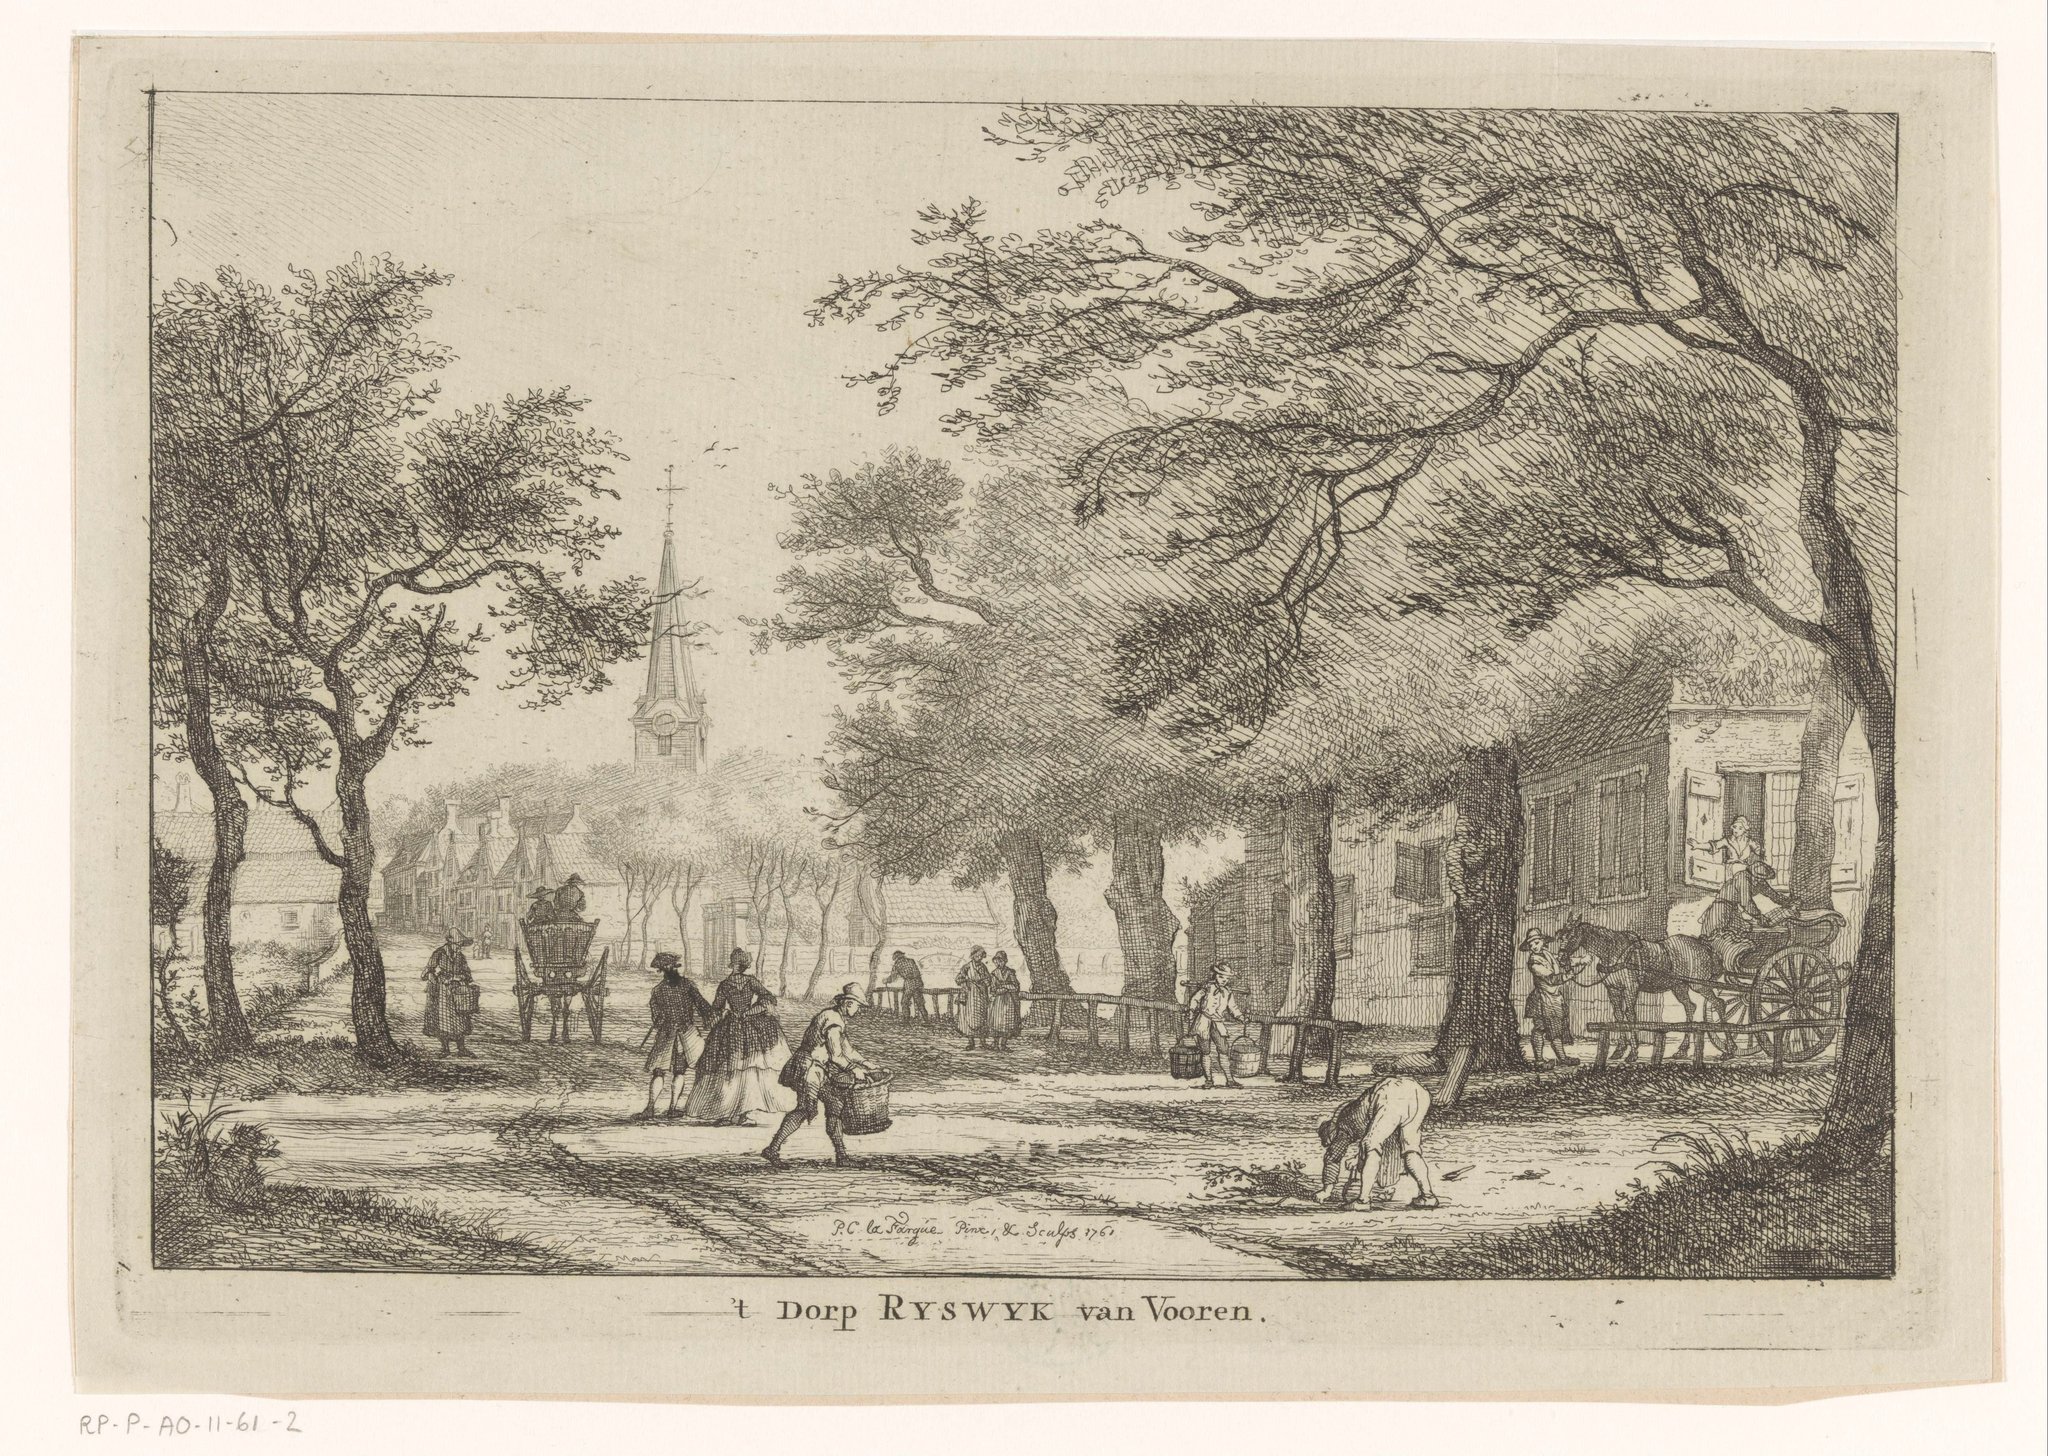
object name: print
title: 't Dorp Ryswyk van vooren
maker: paulus constantijn la fargue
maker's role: draughtsman, painter, print maker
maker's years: 1729-1782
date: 1761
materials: paper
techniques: engraving, etching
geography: the hague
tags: prospect of village, silhouette of village, church (exterior), public road in village (+ city(-scape) with figures, staffage)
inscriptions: collector's mark: Lugt 195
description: Gezicht op het dorp Rijswijk. Op de voorgrond een aantal figuren. Op de achtergrond een kerktoren.